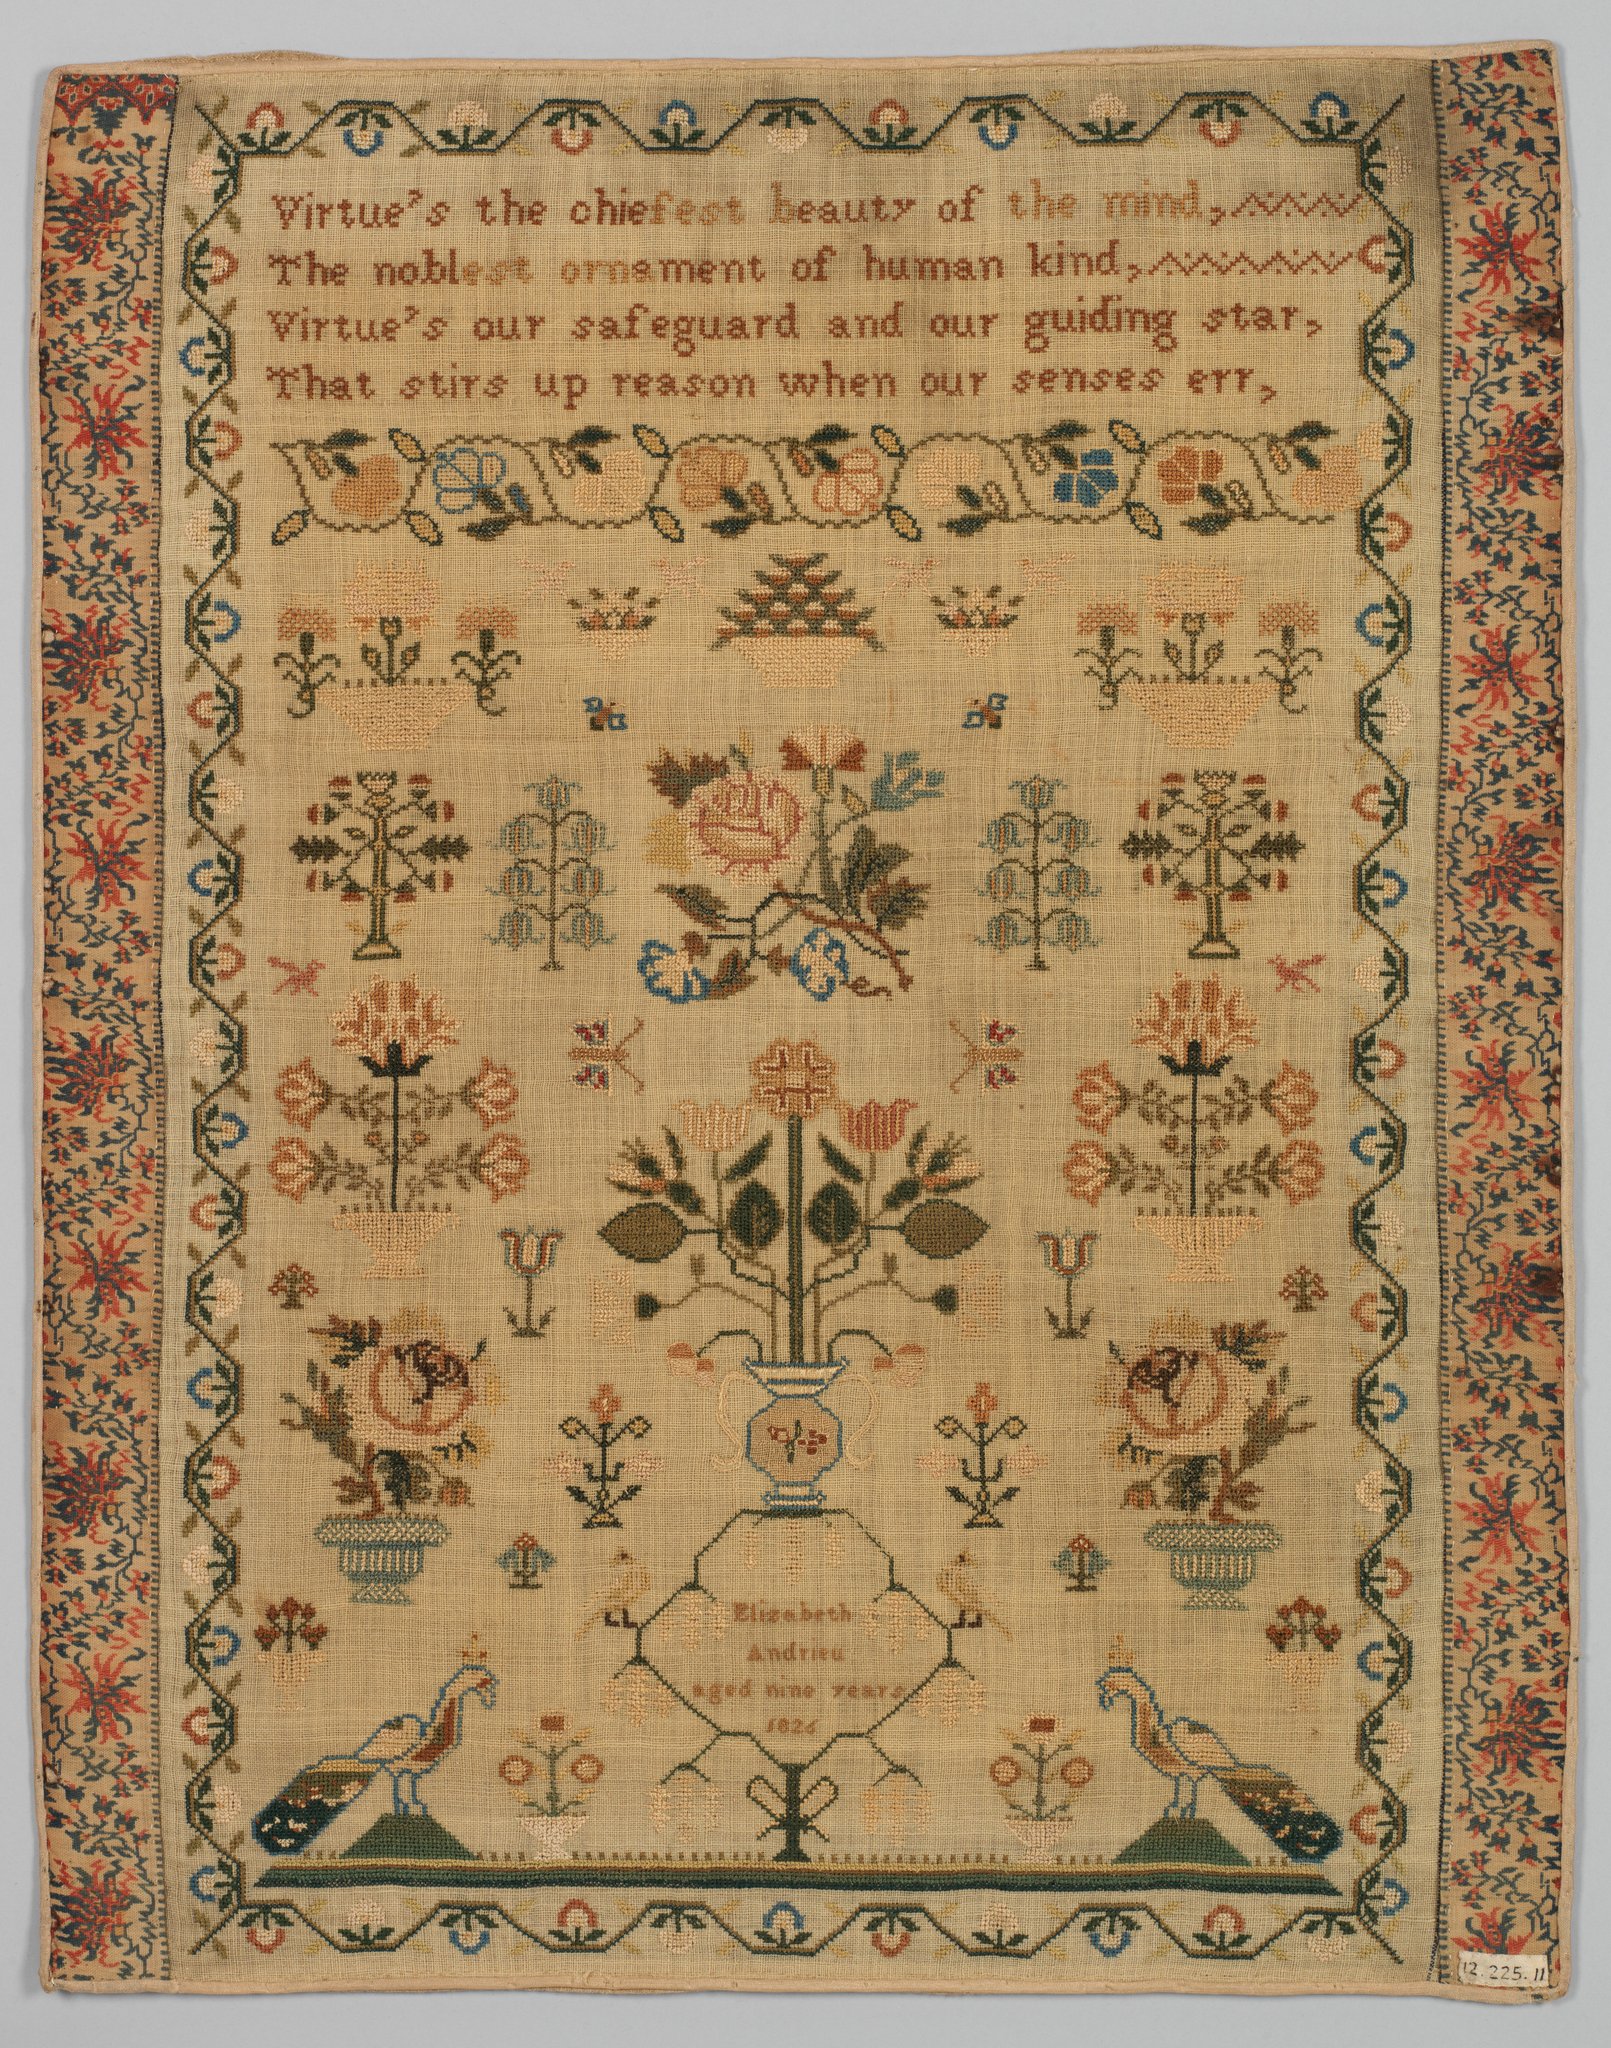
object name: sampler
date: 1826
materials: canvas, silk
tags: peacocks,flowers